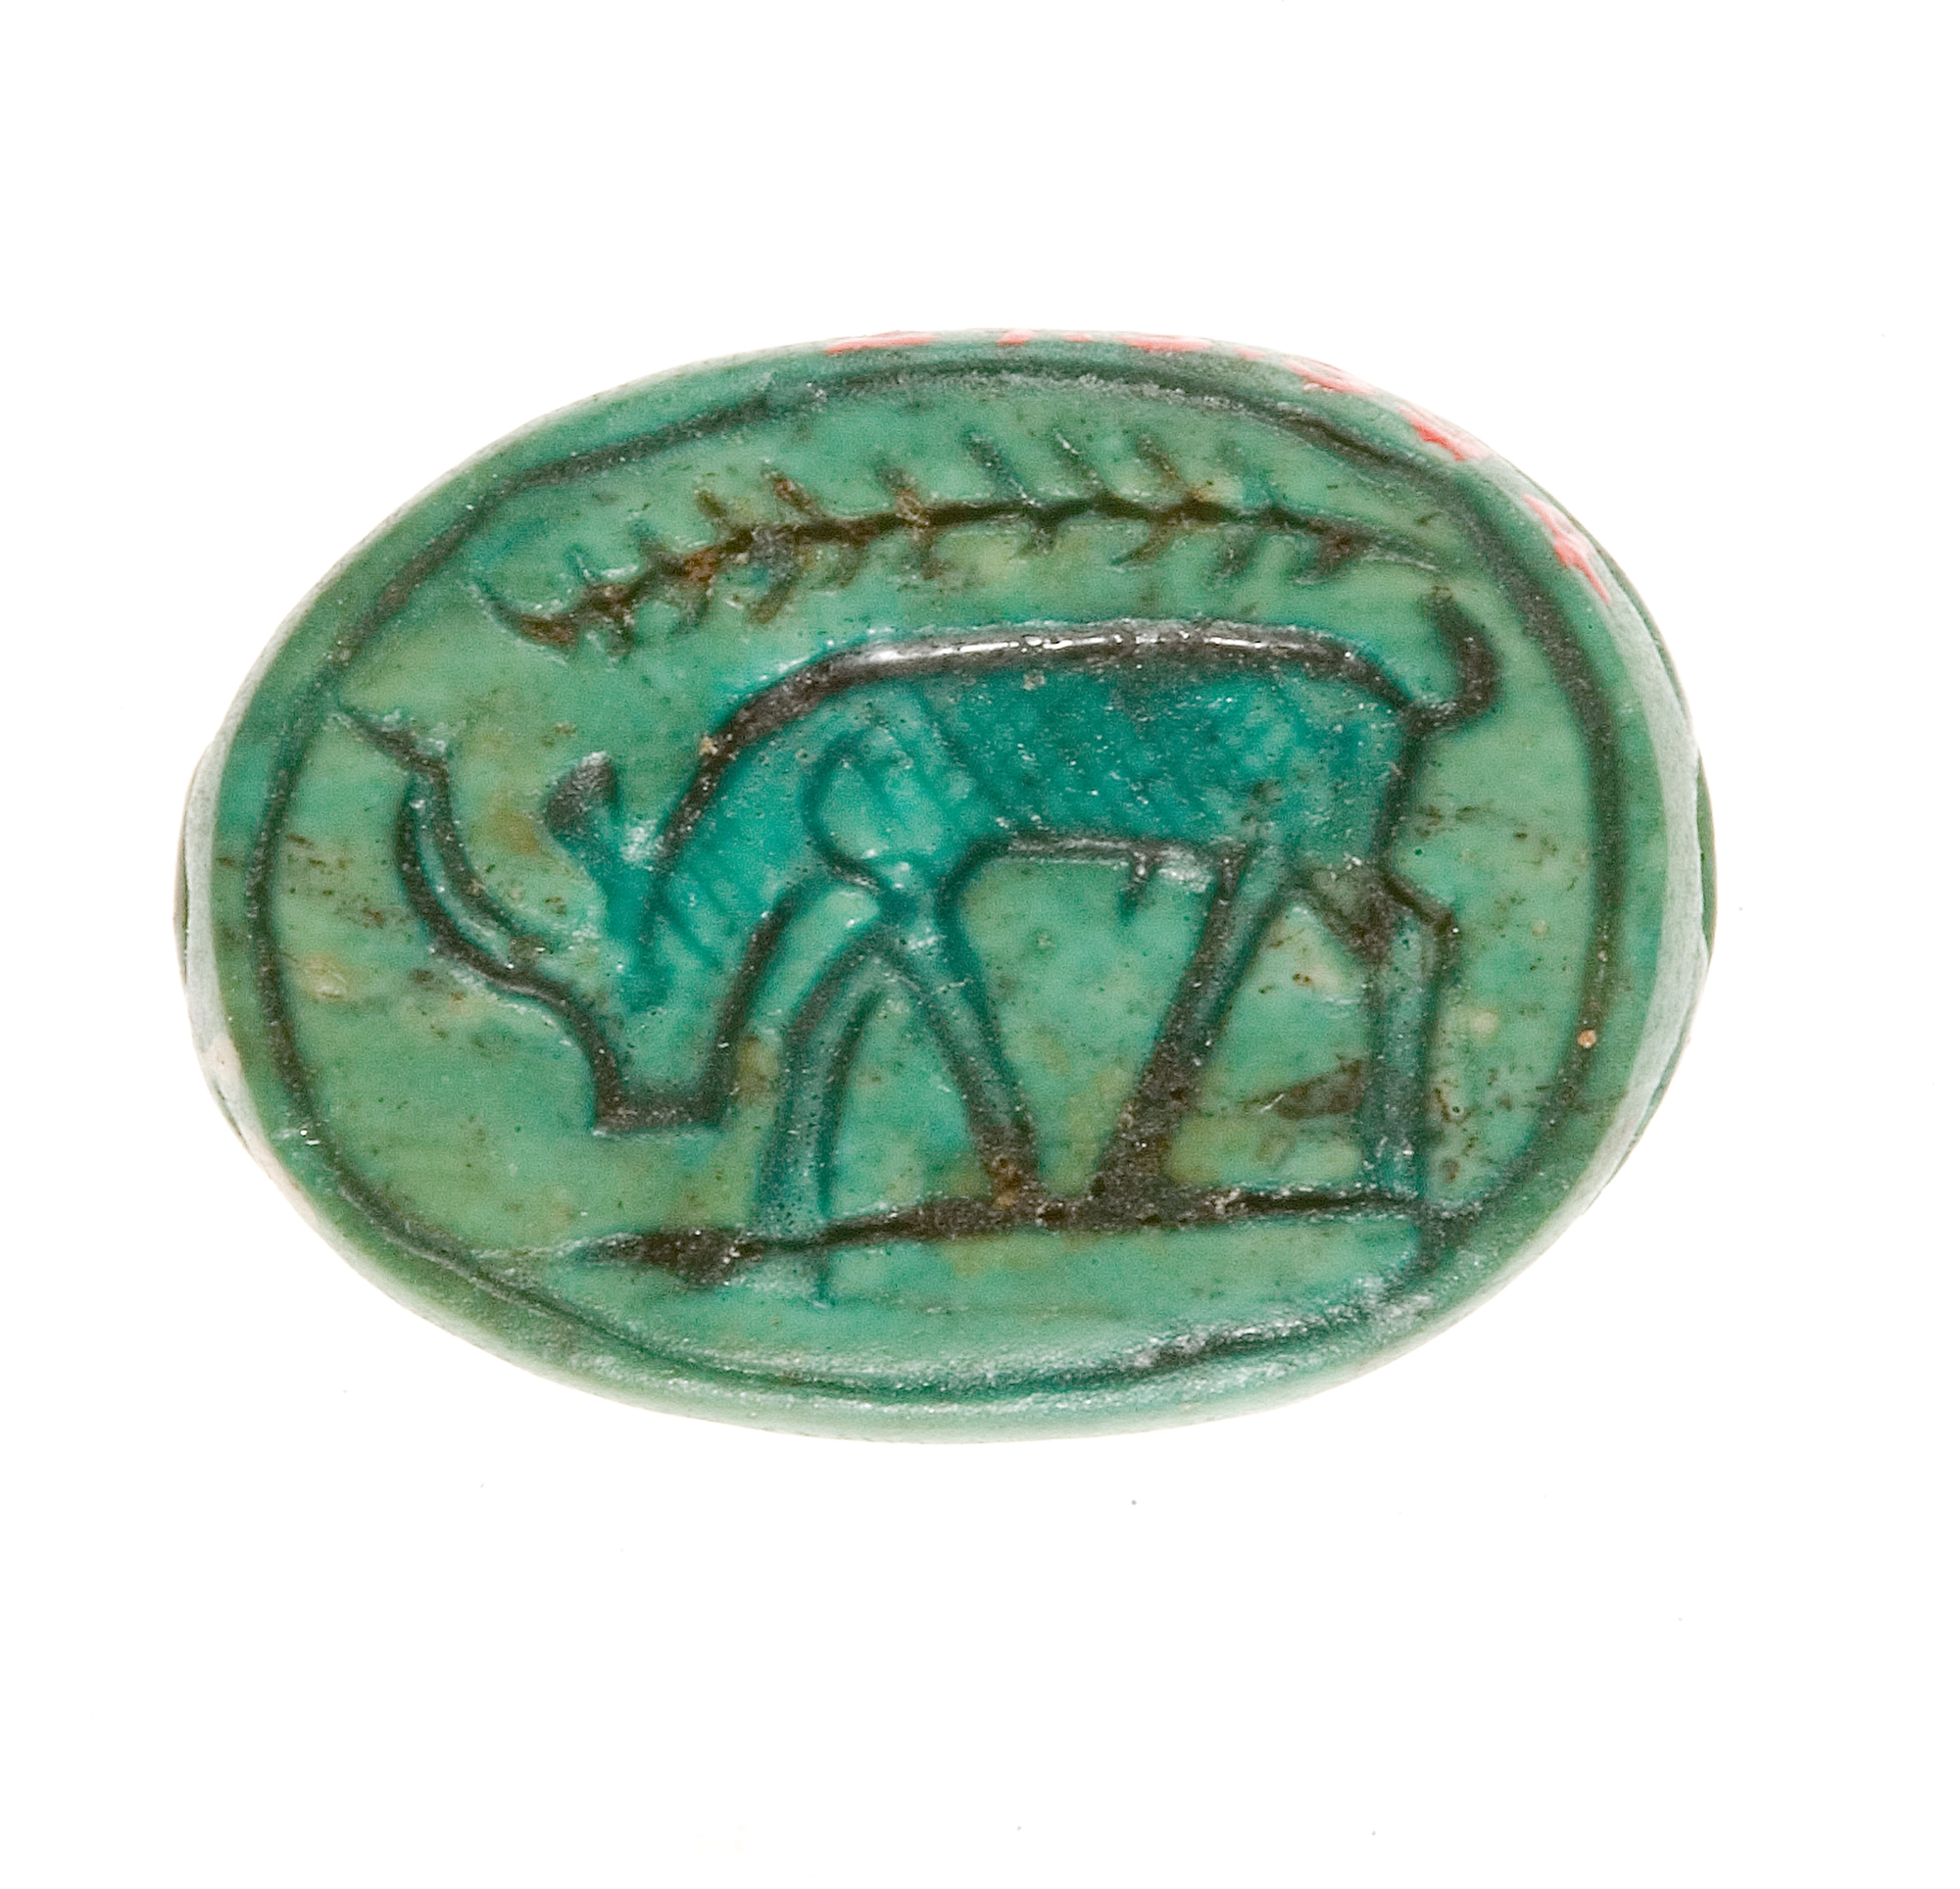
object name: scarab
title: Scarab Inscribed with a Grazing Antelope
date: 1479-1458 BCE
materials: stone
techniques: glazing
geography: egypt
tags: animals,scarabs